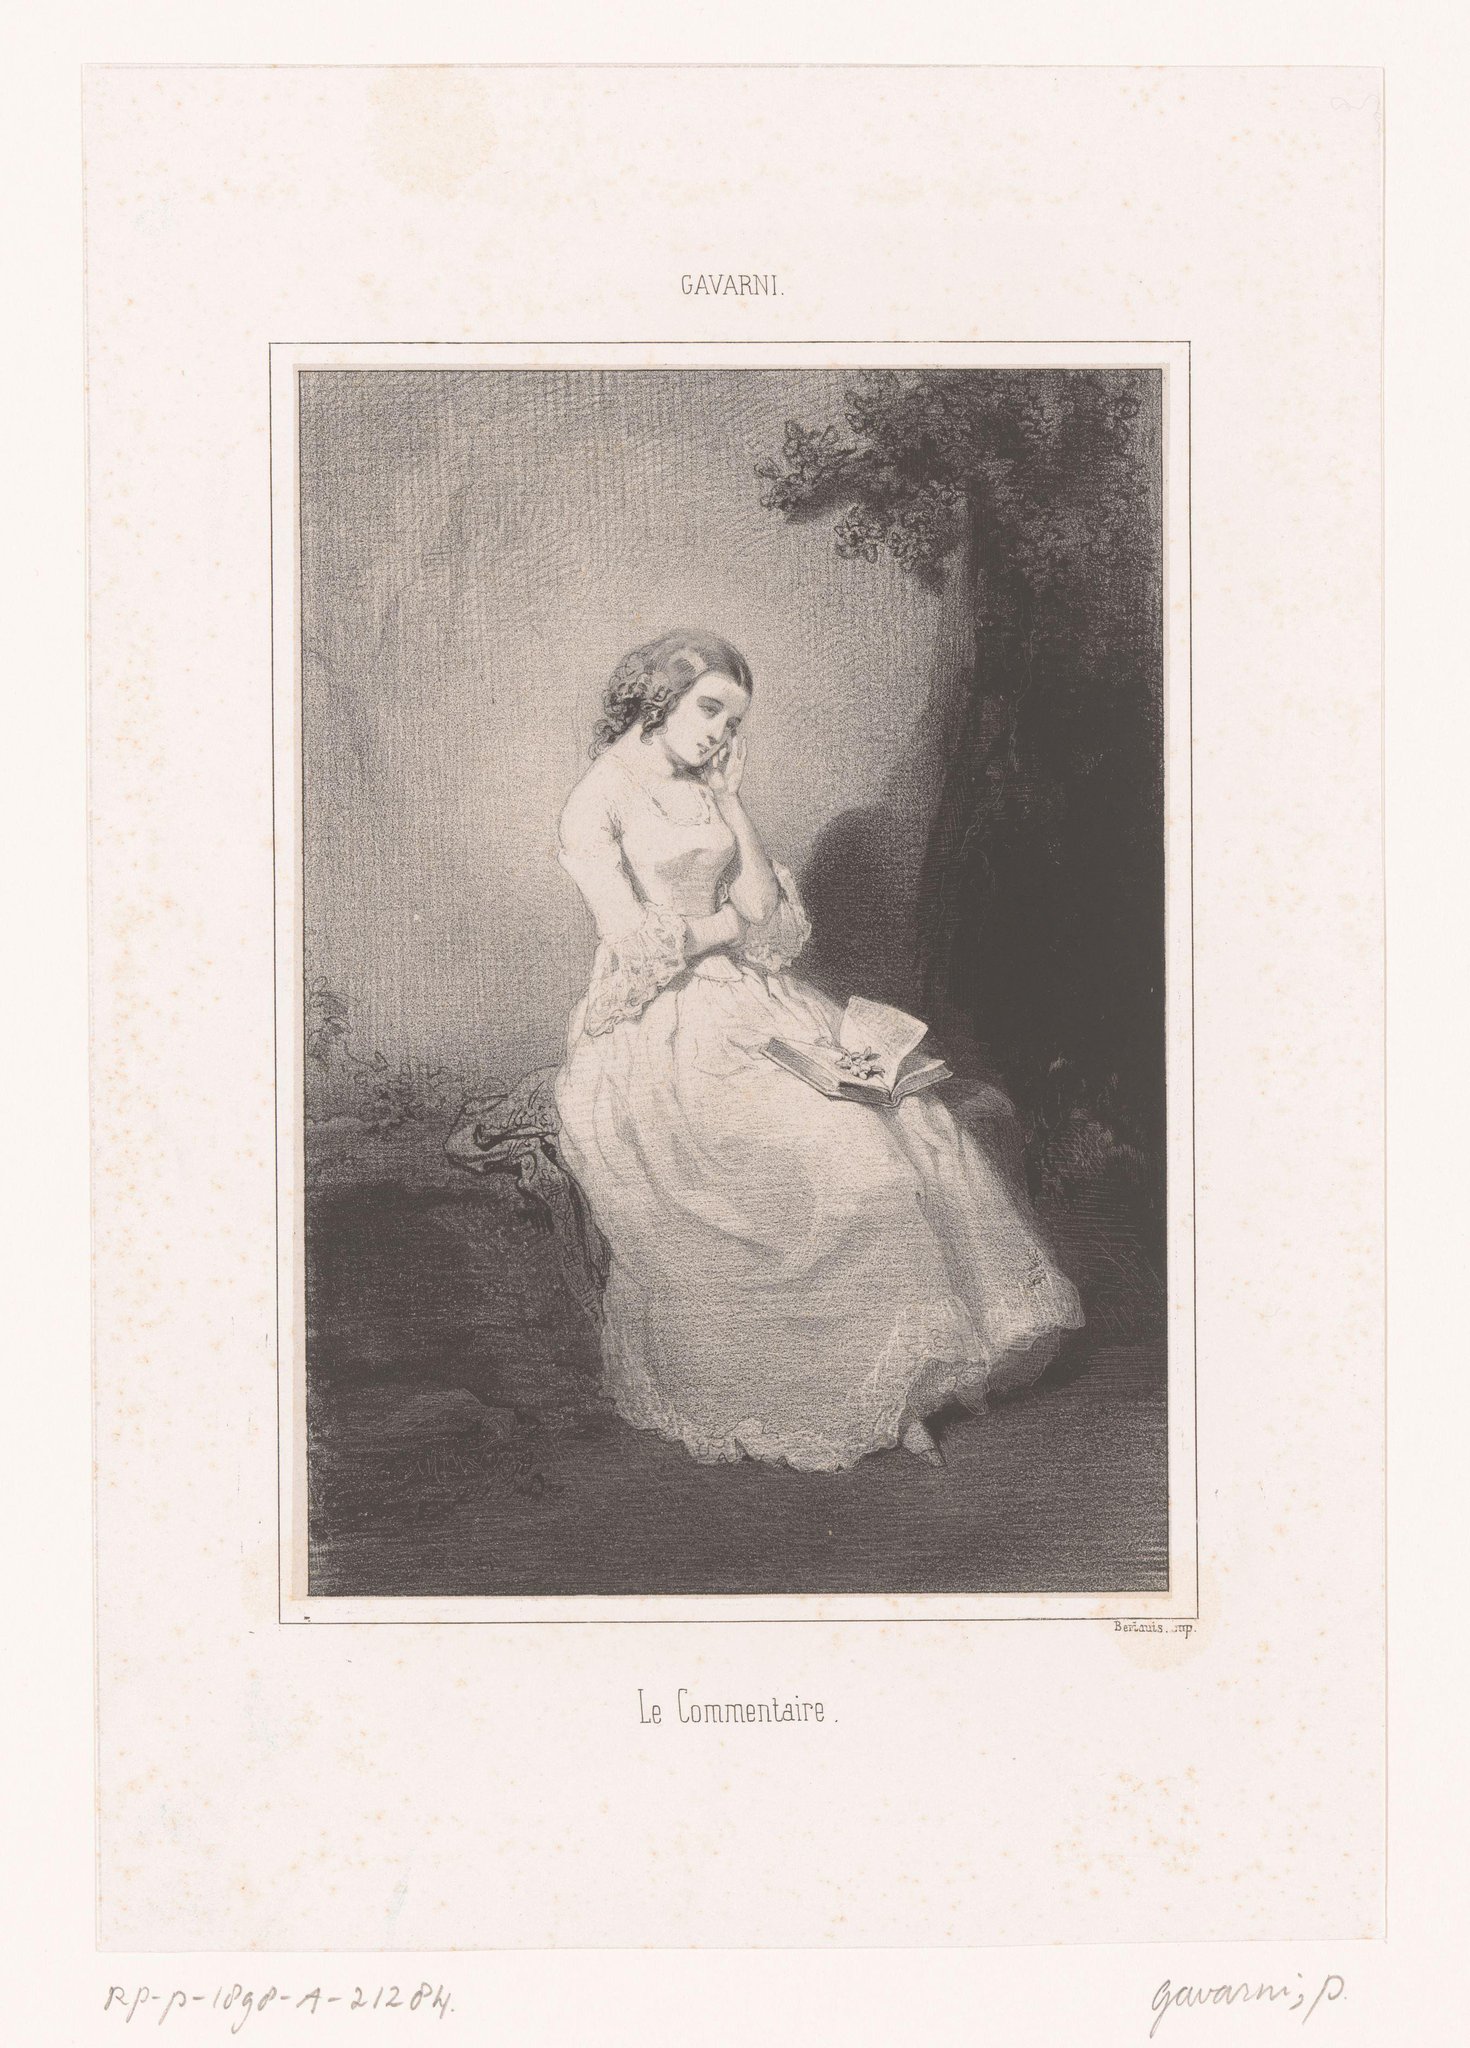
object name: print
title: Le Commentaire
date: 1843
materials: paper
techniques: lithograph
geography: paris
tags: adolescent, young woman, maiden, thinking, thought, reflection; 'pensiero' (ripa), book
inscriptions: check stamp: Lugt 470b, collector's mark: Lugt 964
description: Prent gebruikt voor: Curmer, L. Les Beaux-Arts. Illustration des Arts et de la Littérature. Parijs: L. Curmer, 1843. Vol. 1, 2e livraison.